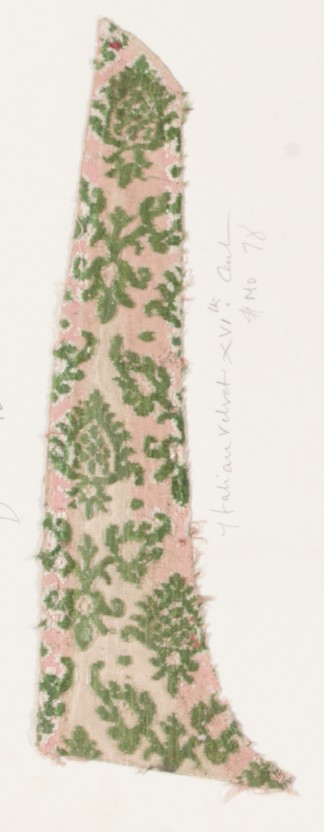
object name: fragment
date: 1601-1700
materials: silk